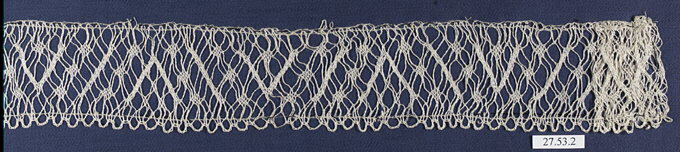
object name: strip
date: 1801-1833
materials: silk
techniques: lace